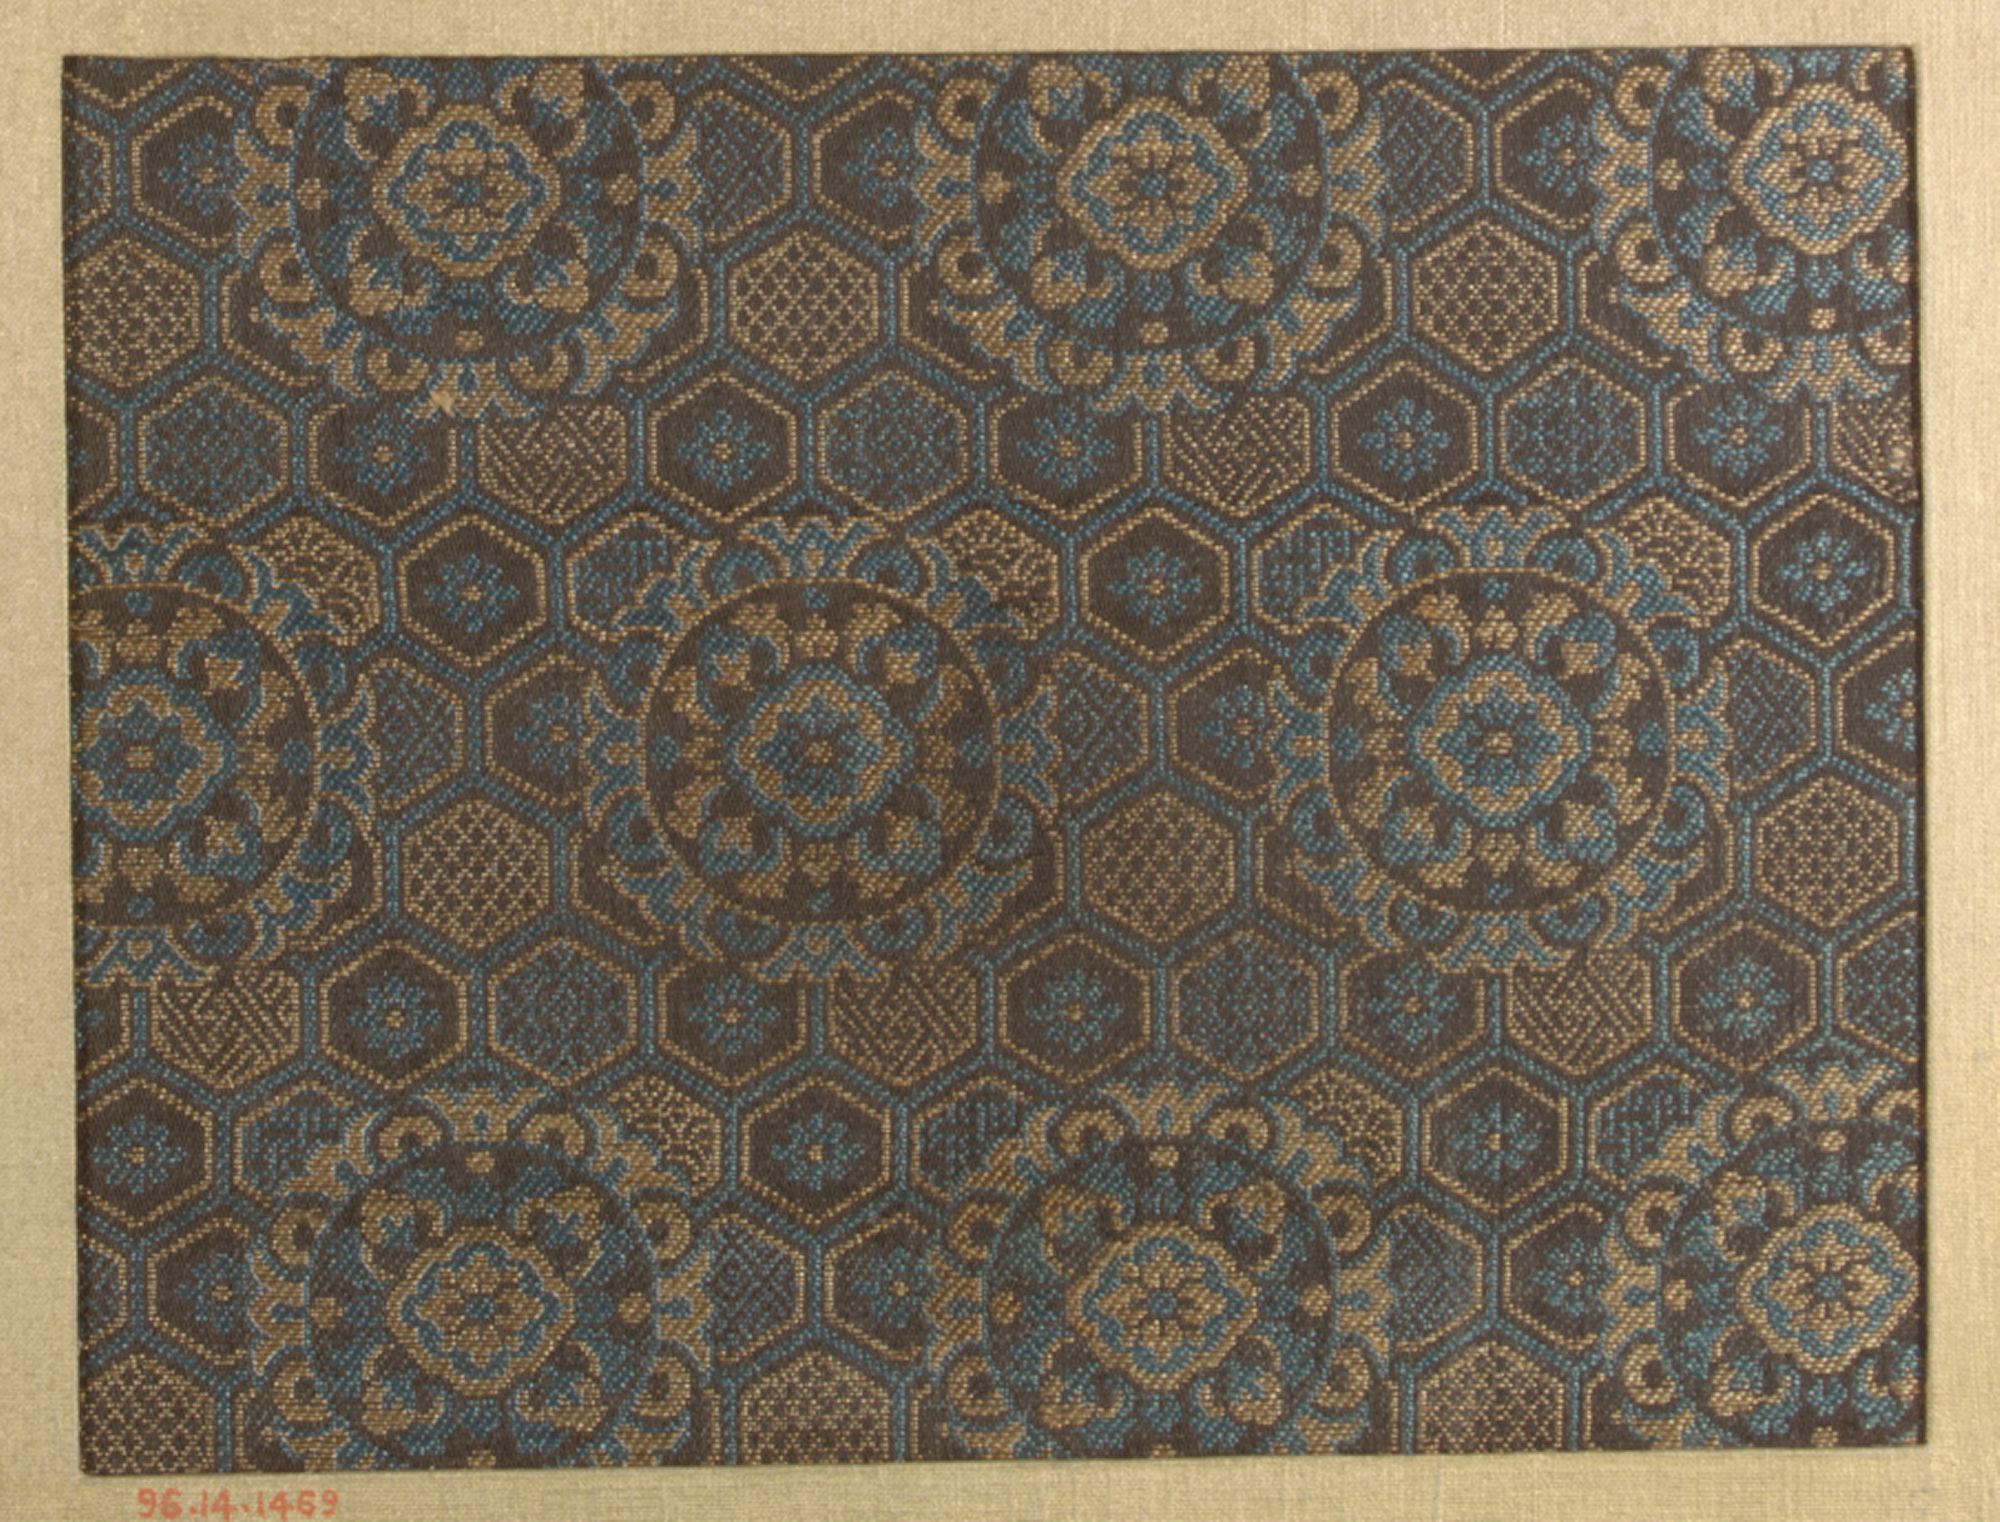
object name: piece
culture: japanese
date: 1701-1900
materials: silk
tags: flowers